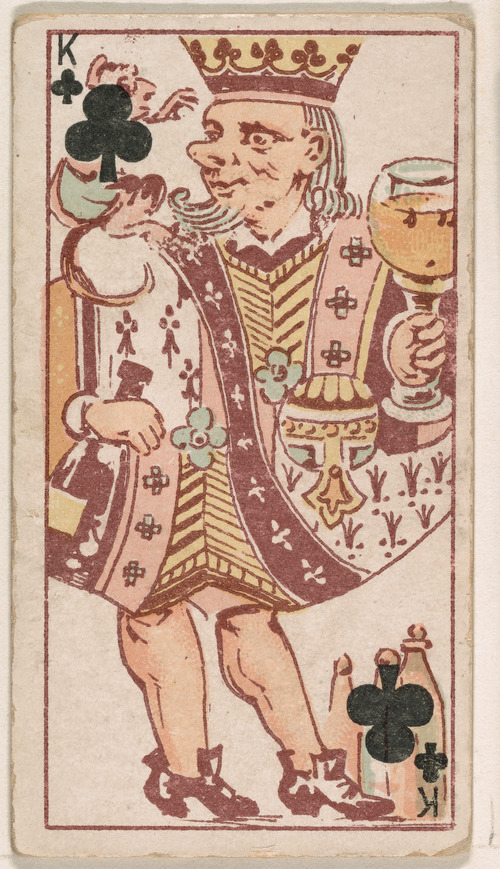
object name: print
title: King of Clubs, from Harlequin Cards, 2nd Series (N220) issued by Kinney Bros.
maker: kinney brothers tobacco company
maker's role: publisher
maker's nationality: american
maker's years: 1869-2011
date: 1889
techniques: color lithograph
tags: kings,playing cards